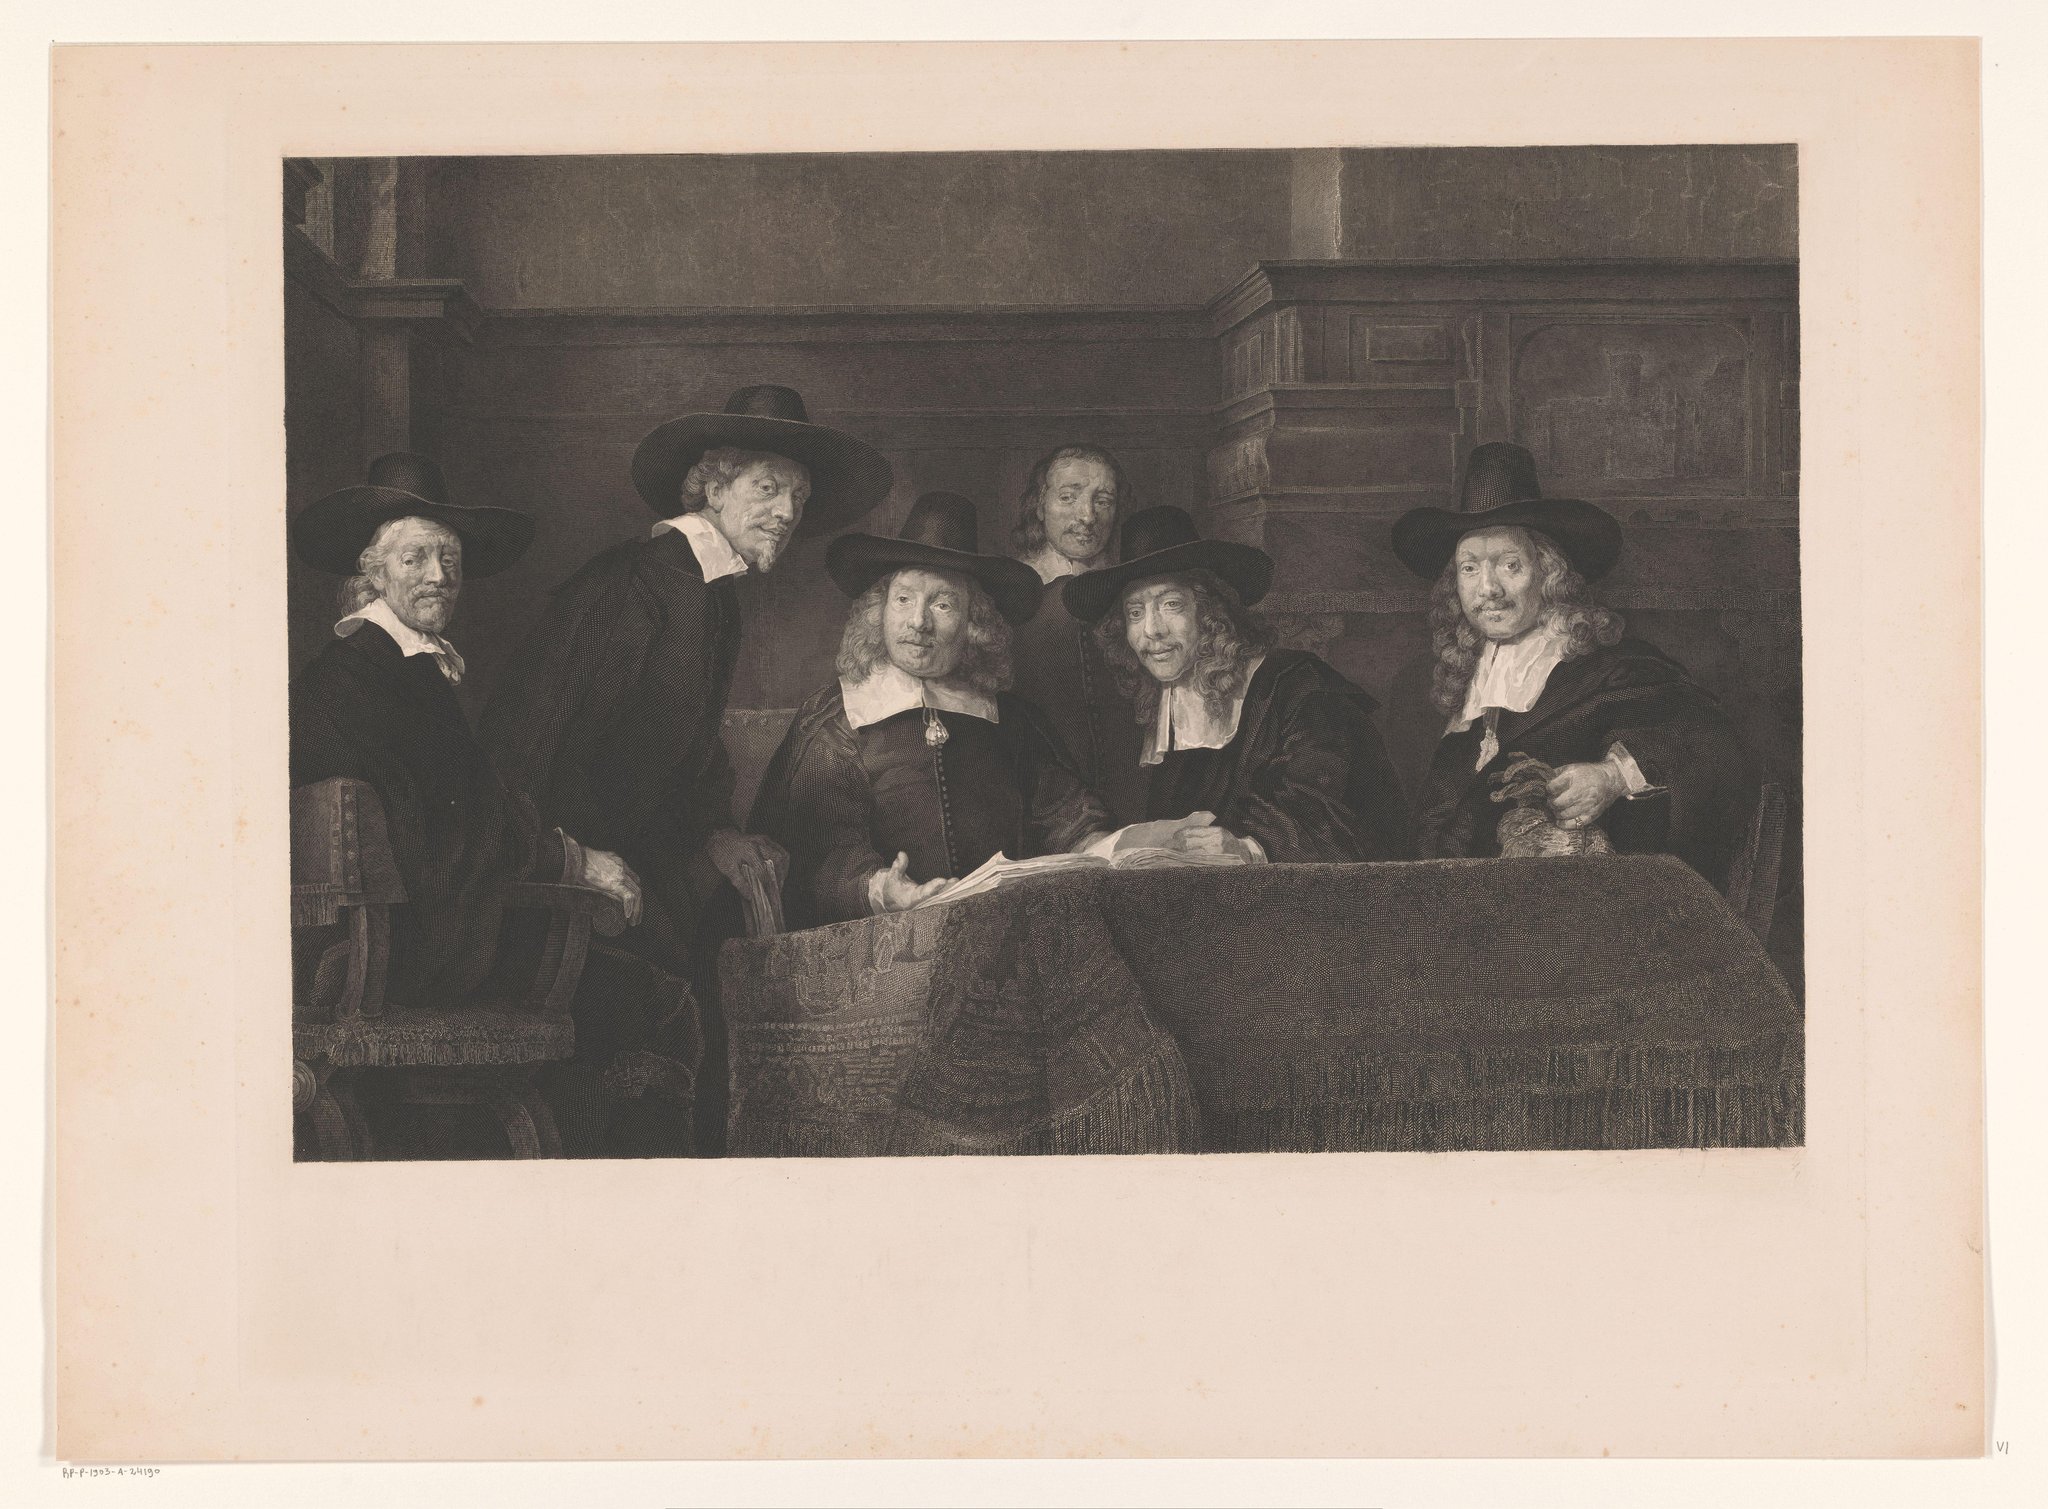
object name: print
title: De waardijns van het Amsterdamse lakenbereidersgilde, bekend als ‘De Staalmeesters’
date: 1846-1900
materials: paper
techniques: engraving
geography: netherlands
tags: control of quality, amsterdam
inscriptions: collector's mark: Lugt 2228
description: De Staalmeesters: het college van staalmeesters of waardijns van het Amsterdamse lakenbereidersgilde, bijeen rond een tafel waarop een Perzisch kleed ligt. Op tafel het opengeslagen stalenboek. Voorgesteld zijn van links naar rechts: Jochem de Neve (1629-81), Aernout van der Mye (ca. 1625-81), de knecht Frans Hendricksz Bel (1629-1701), Willem van Doeyenburg (ca. 1616-87), Volckert Jansz (1605/10-81), Jacob van Loon (1595-1674). Links boven de haard een schilderij met een brandend baken.